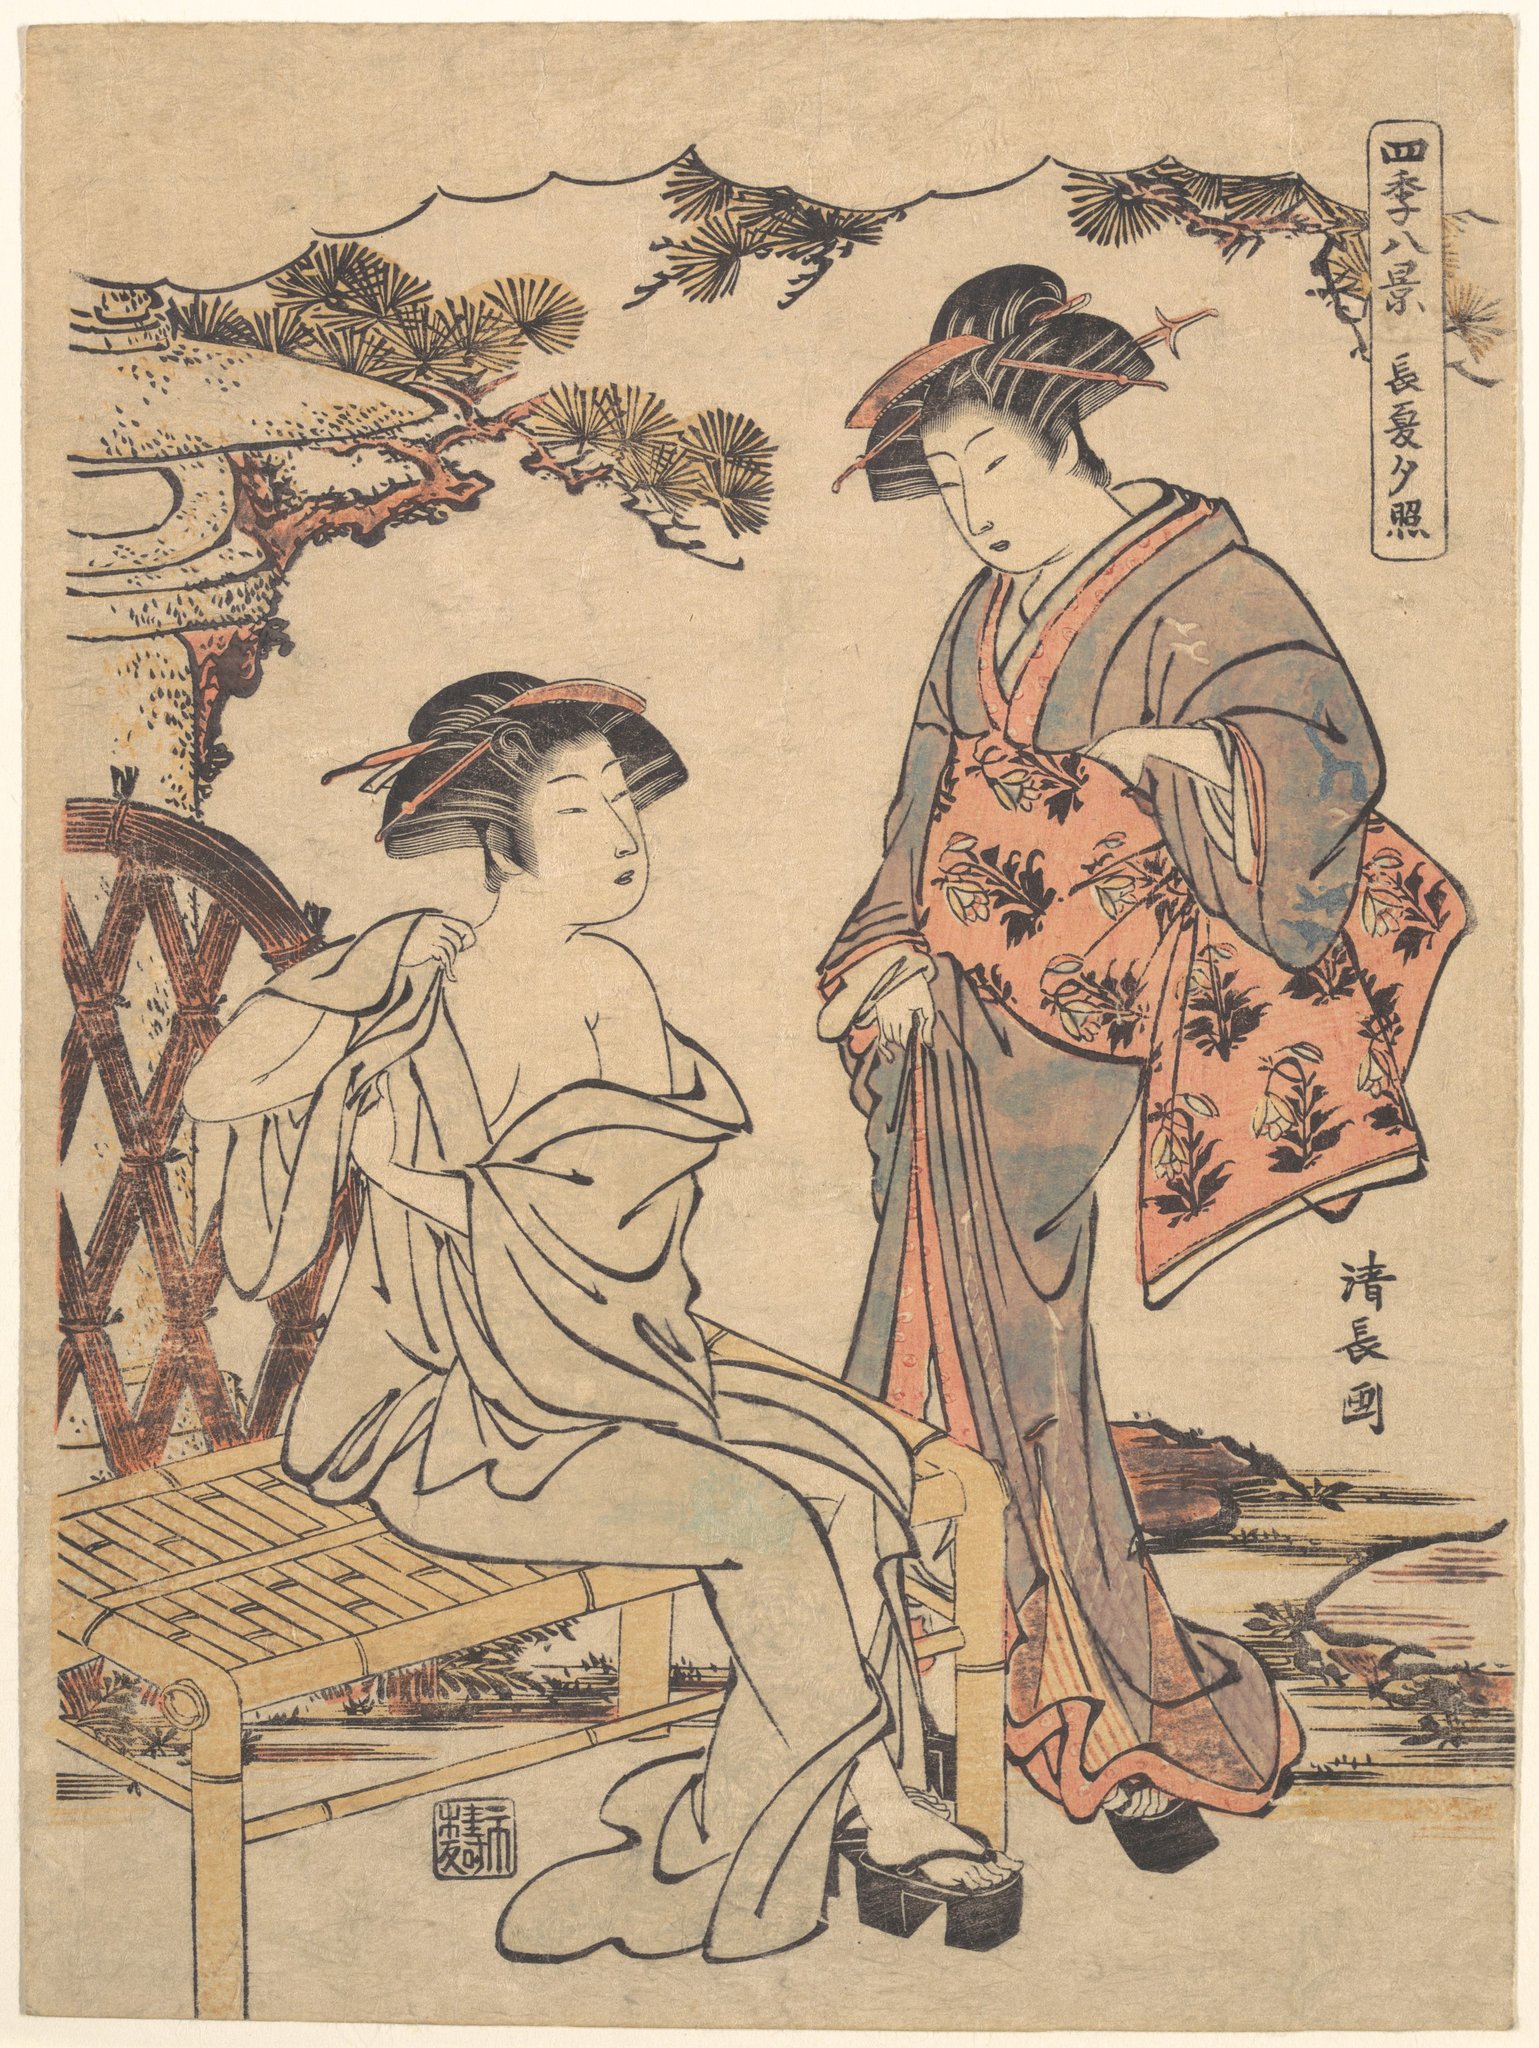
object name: print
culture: japanese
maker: torii kiyonaga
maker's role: artist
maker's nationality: japanese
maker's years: 1752-1815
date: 1742-1815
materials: ink, paper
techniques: woodblock print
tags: women